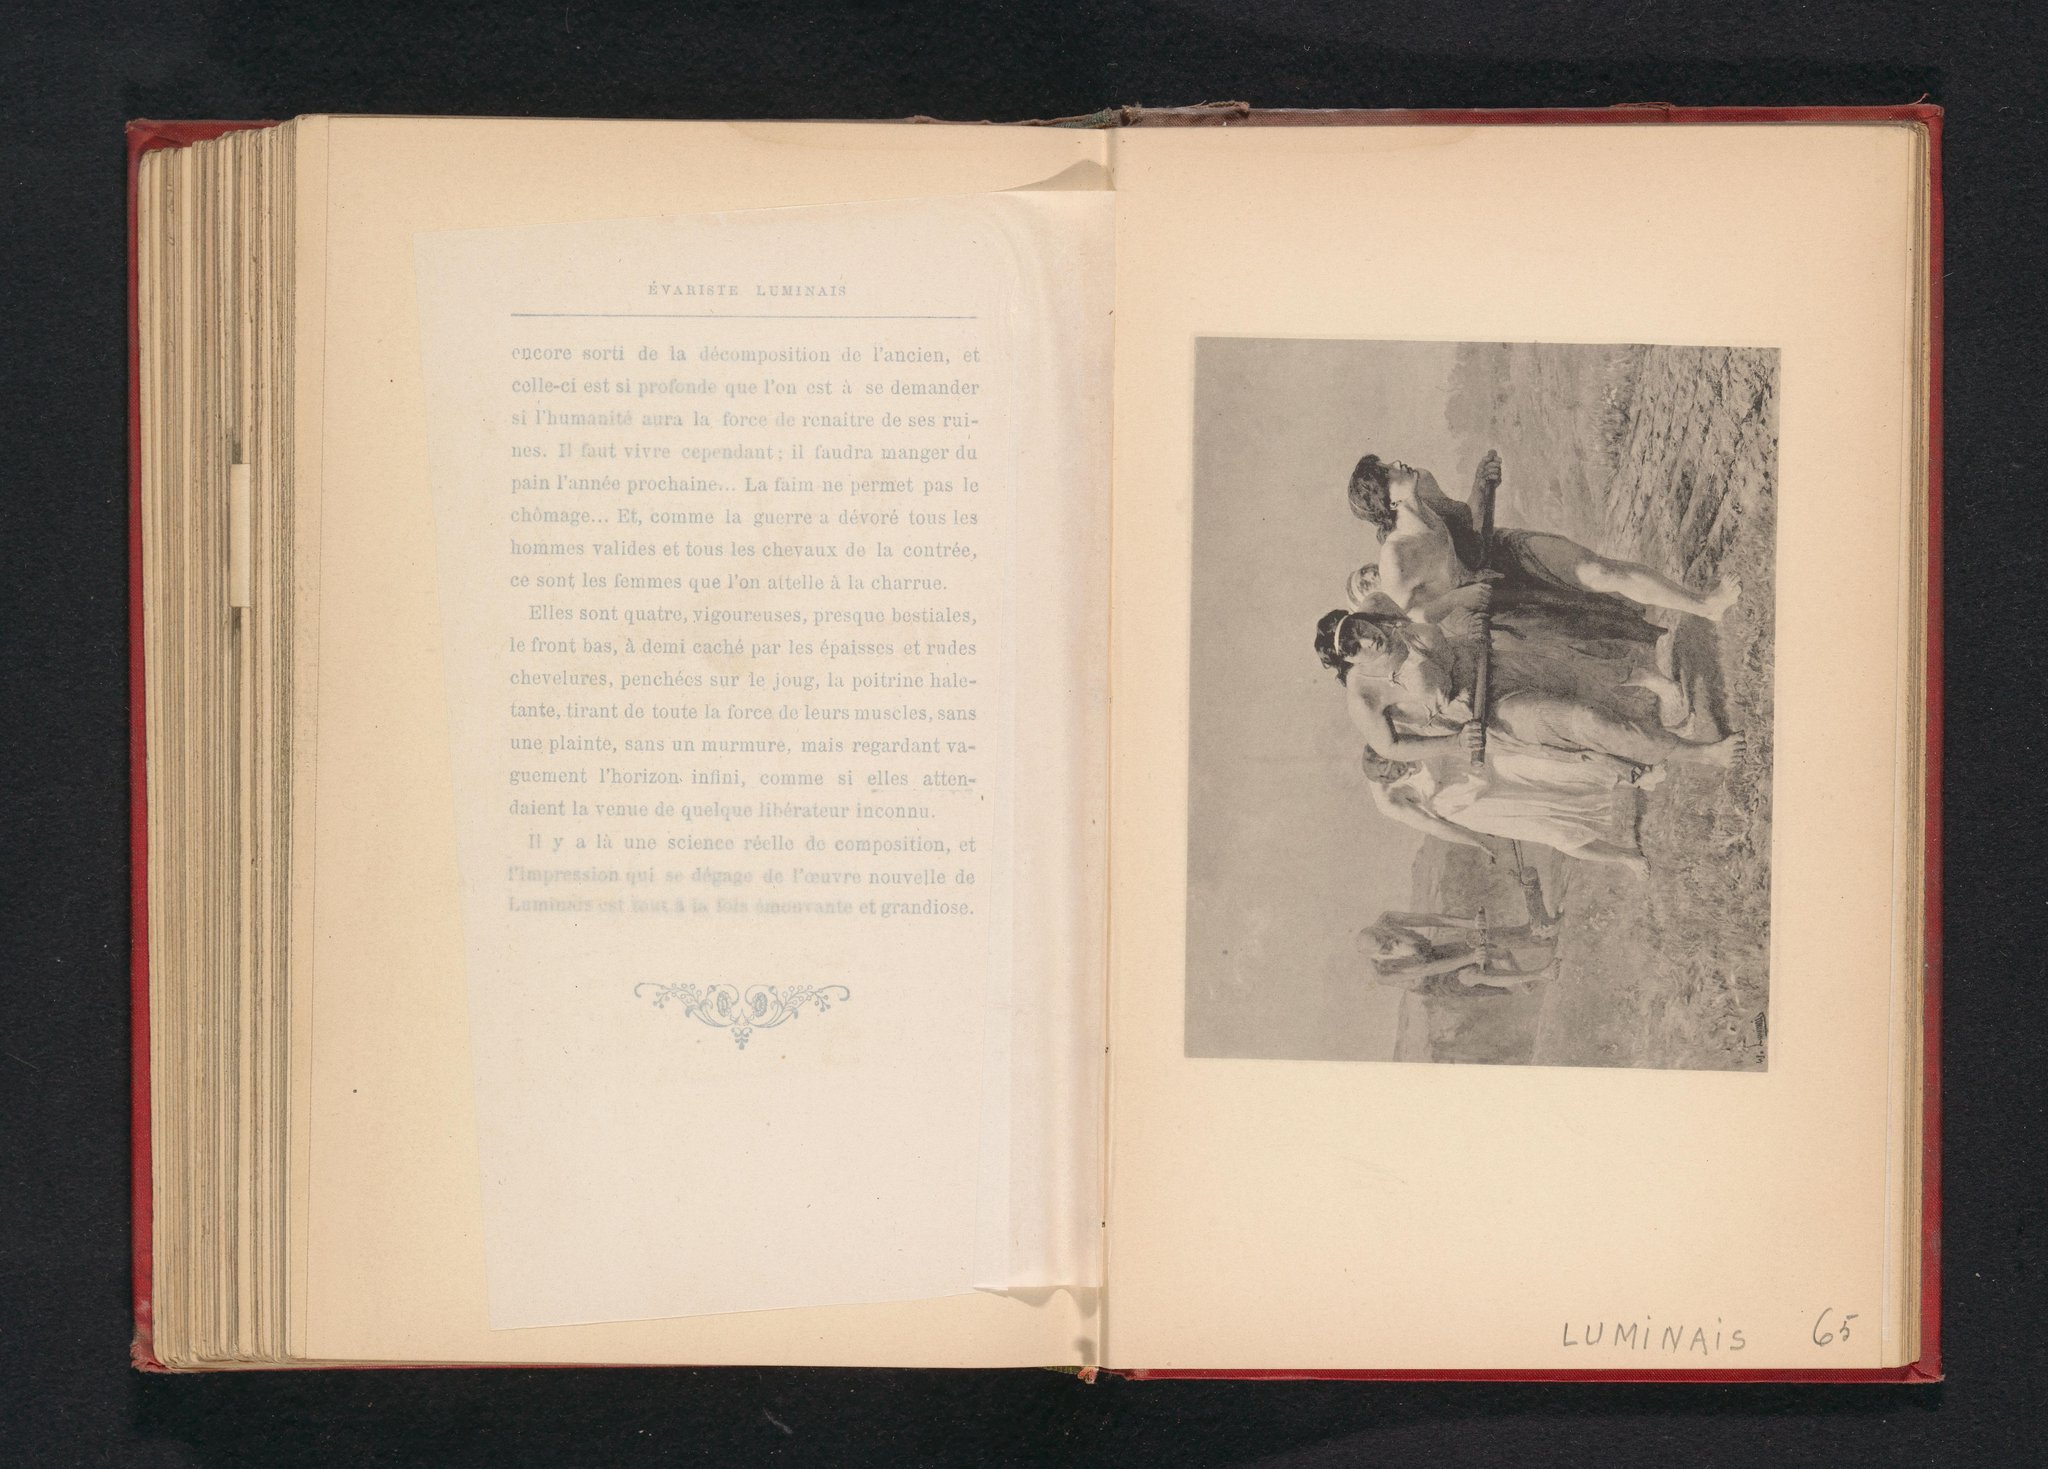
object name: reproduction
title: Fotoreproductie van het schilderij Pendant la guerre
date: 1872-1882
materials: paper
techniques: photograph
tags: agricultural implements: plough, ploughing